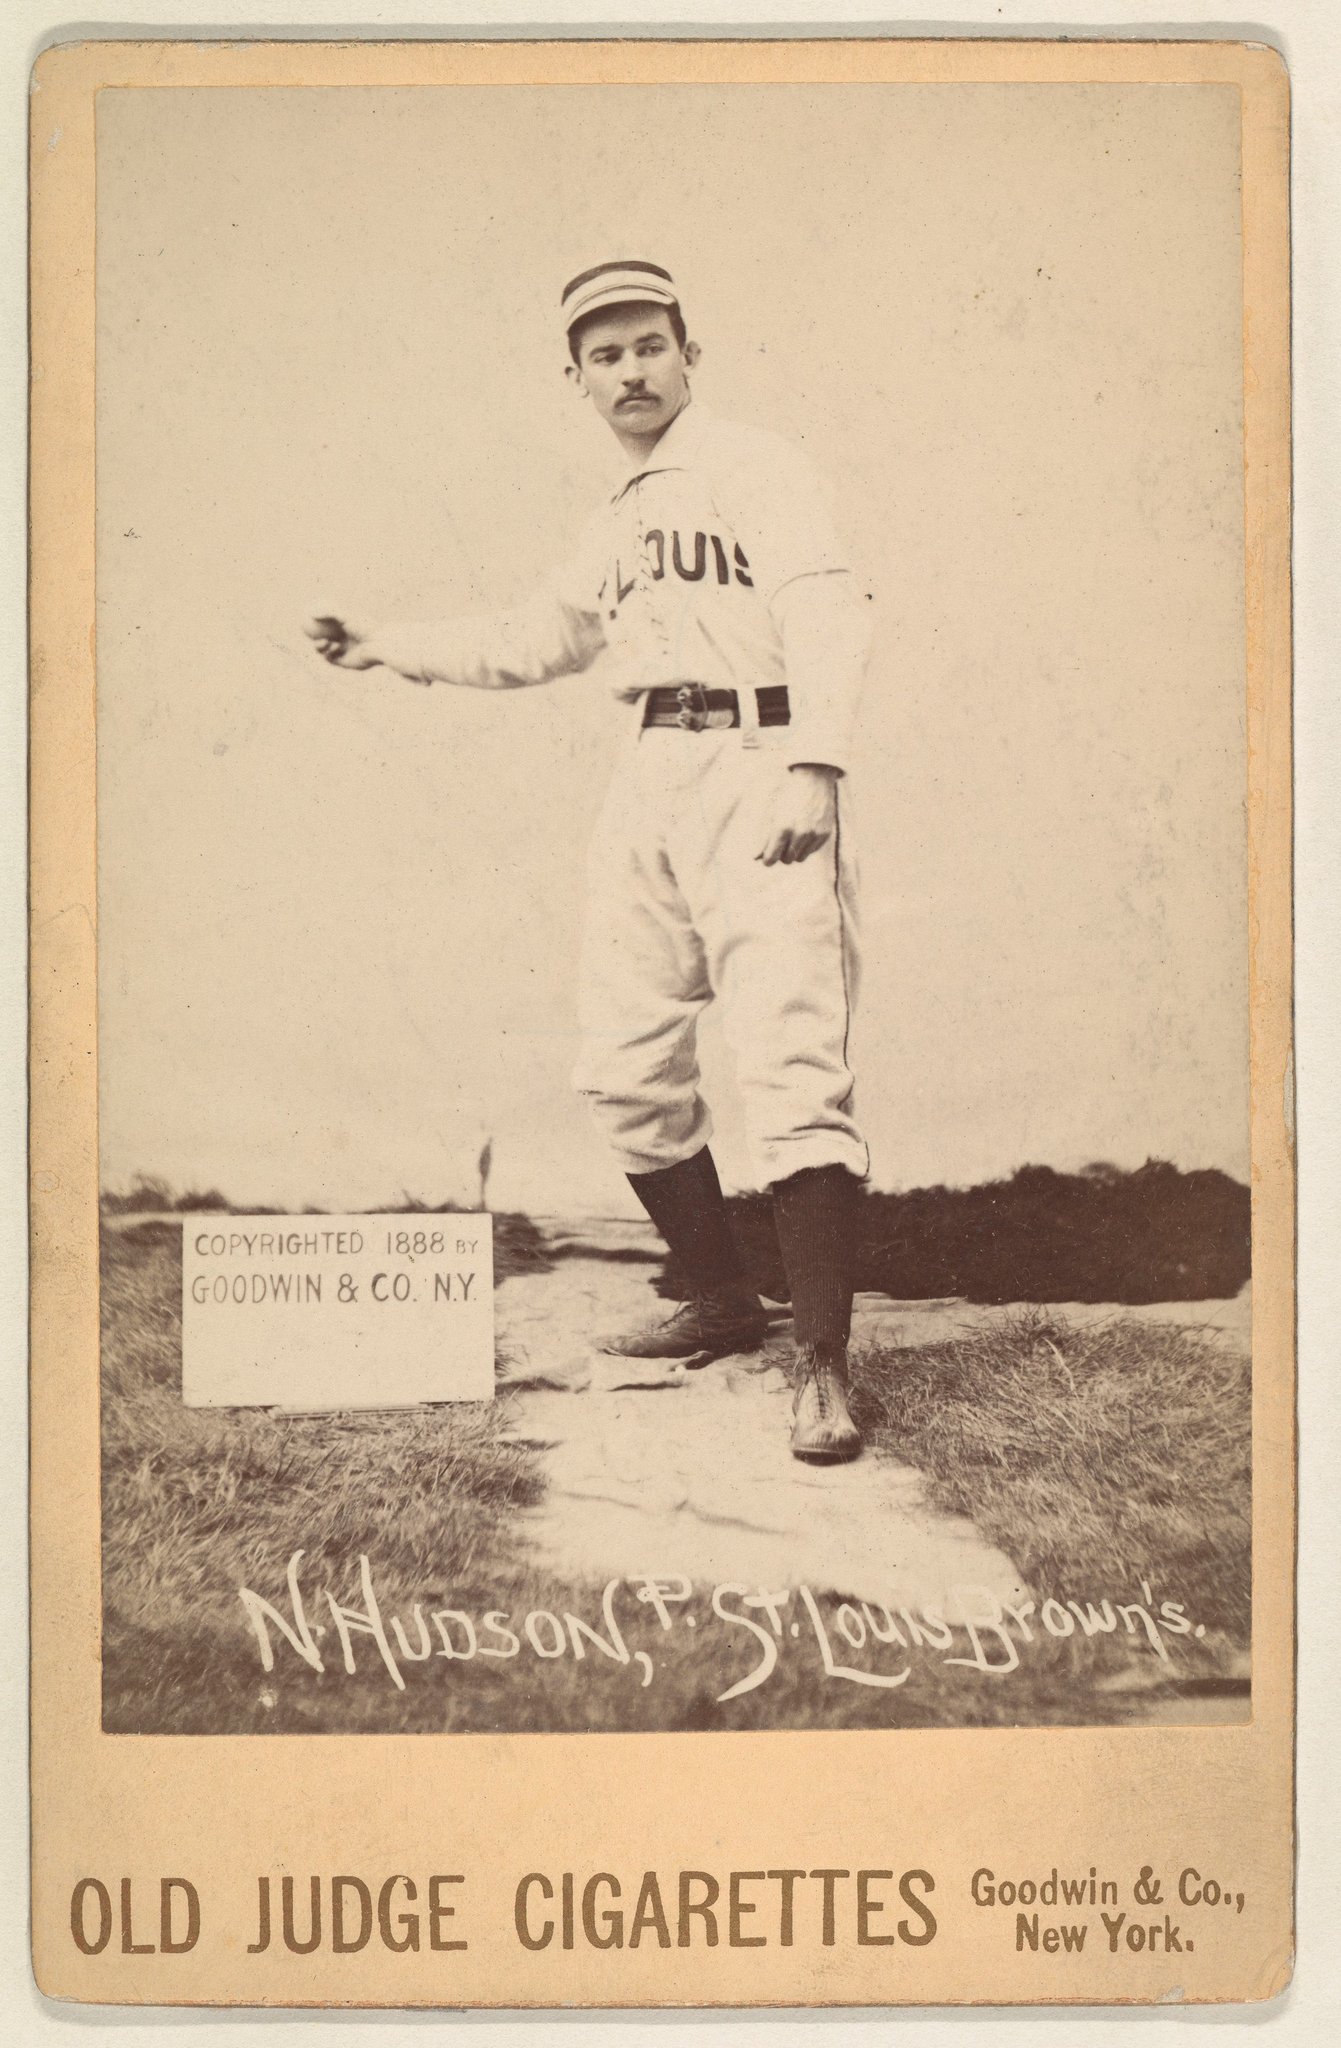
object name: baseball card, photograph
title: N. Hudson, Pitcher, St. Louis Browns, from the series Old Judge Cigarettes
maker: goodwin & company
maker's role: publisher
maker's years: 1850-1950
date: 1888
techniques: albumen print, photography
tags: men,portraits,baseball,athletes